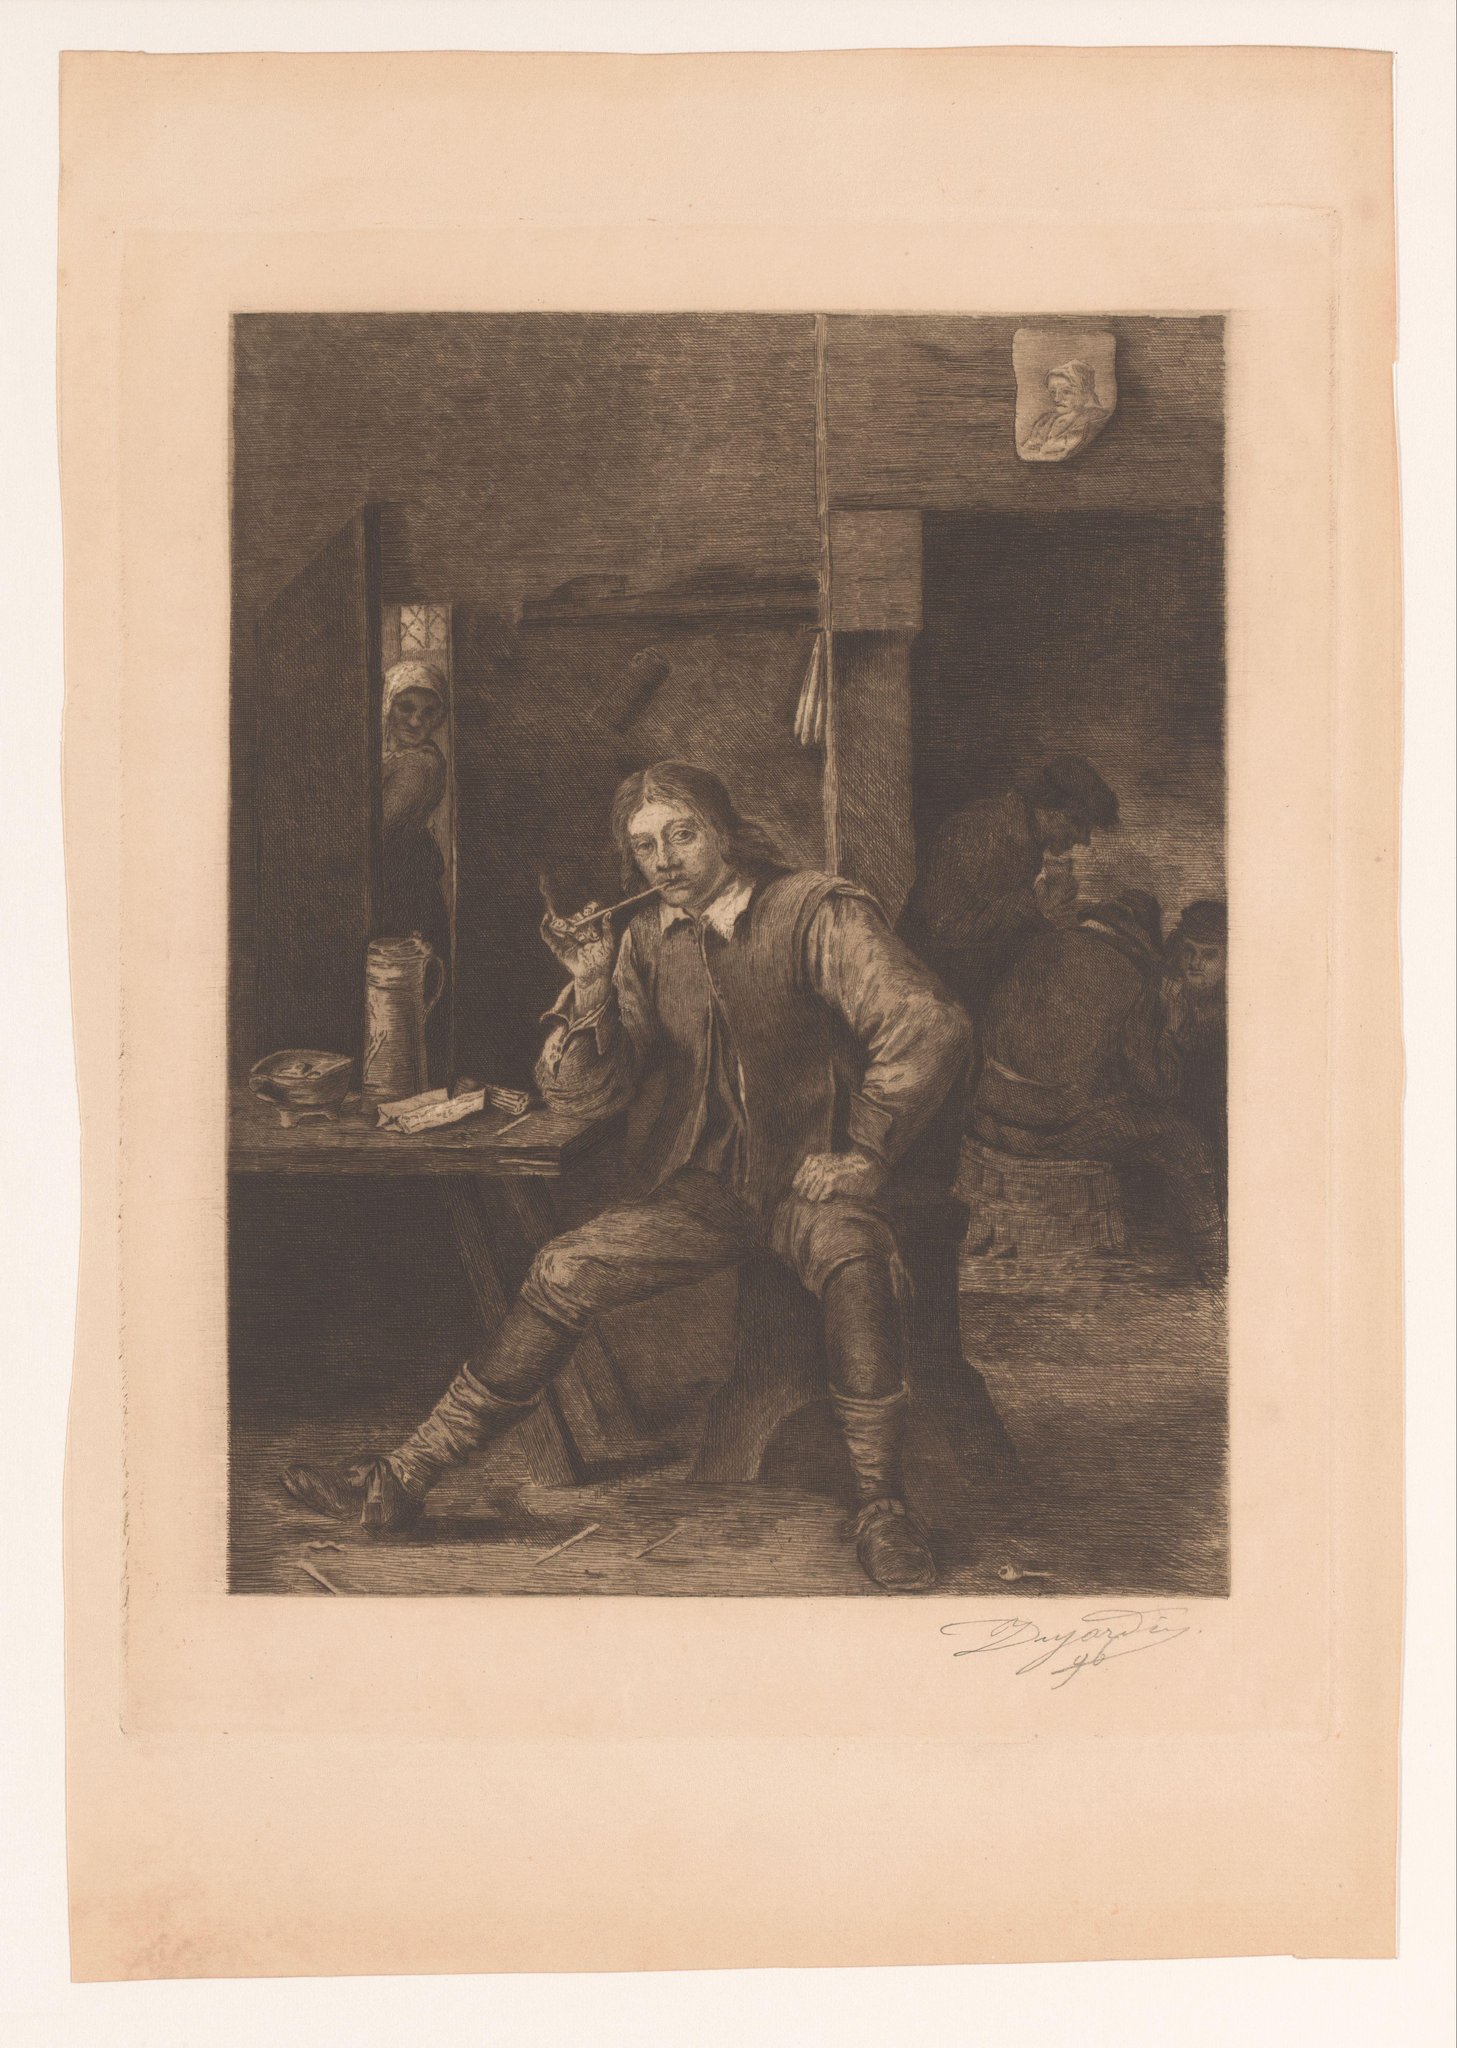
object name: print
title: Herberg met pijp rokende man, een vrouw in de deuropening en kaartende mannen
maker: joseph dujardin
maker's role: print maker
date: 1896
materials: paper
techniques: etching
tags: pipe ~ tobacco, playing-cards, hotel, hostelry, inn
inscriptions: collector's mark: Lugt 2228